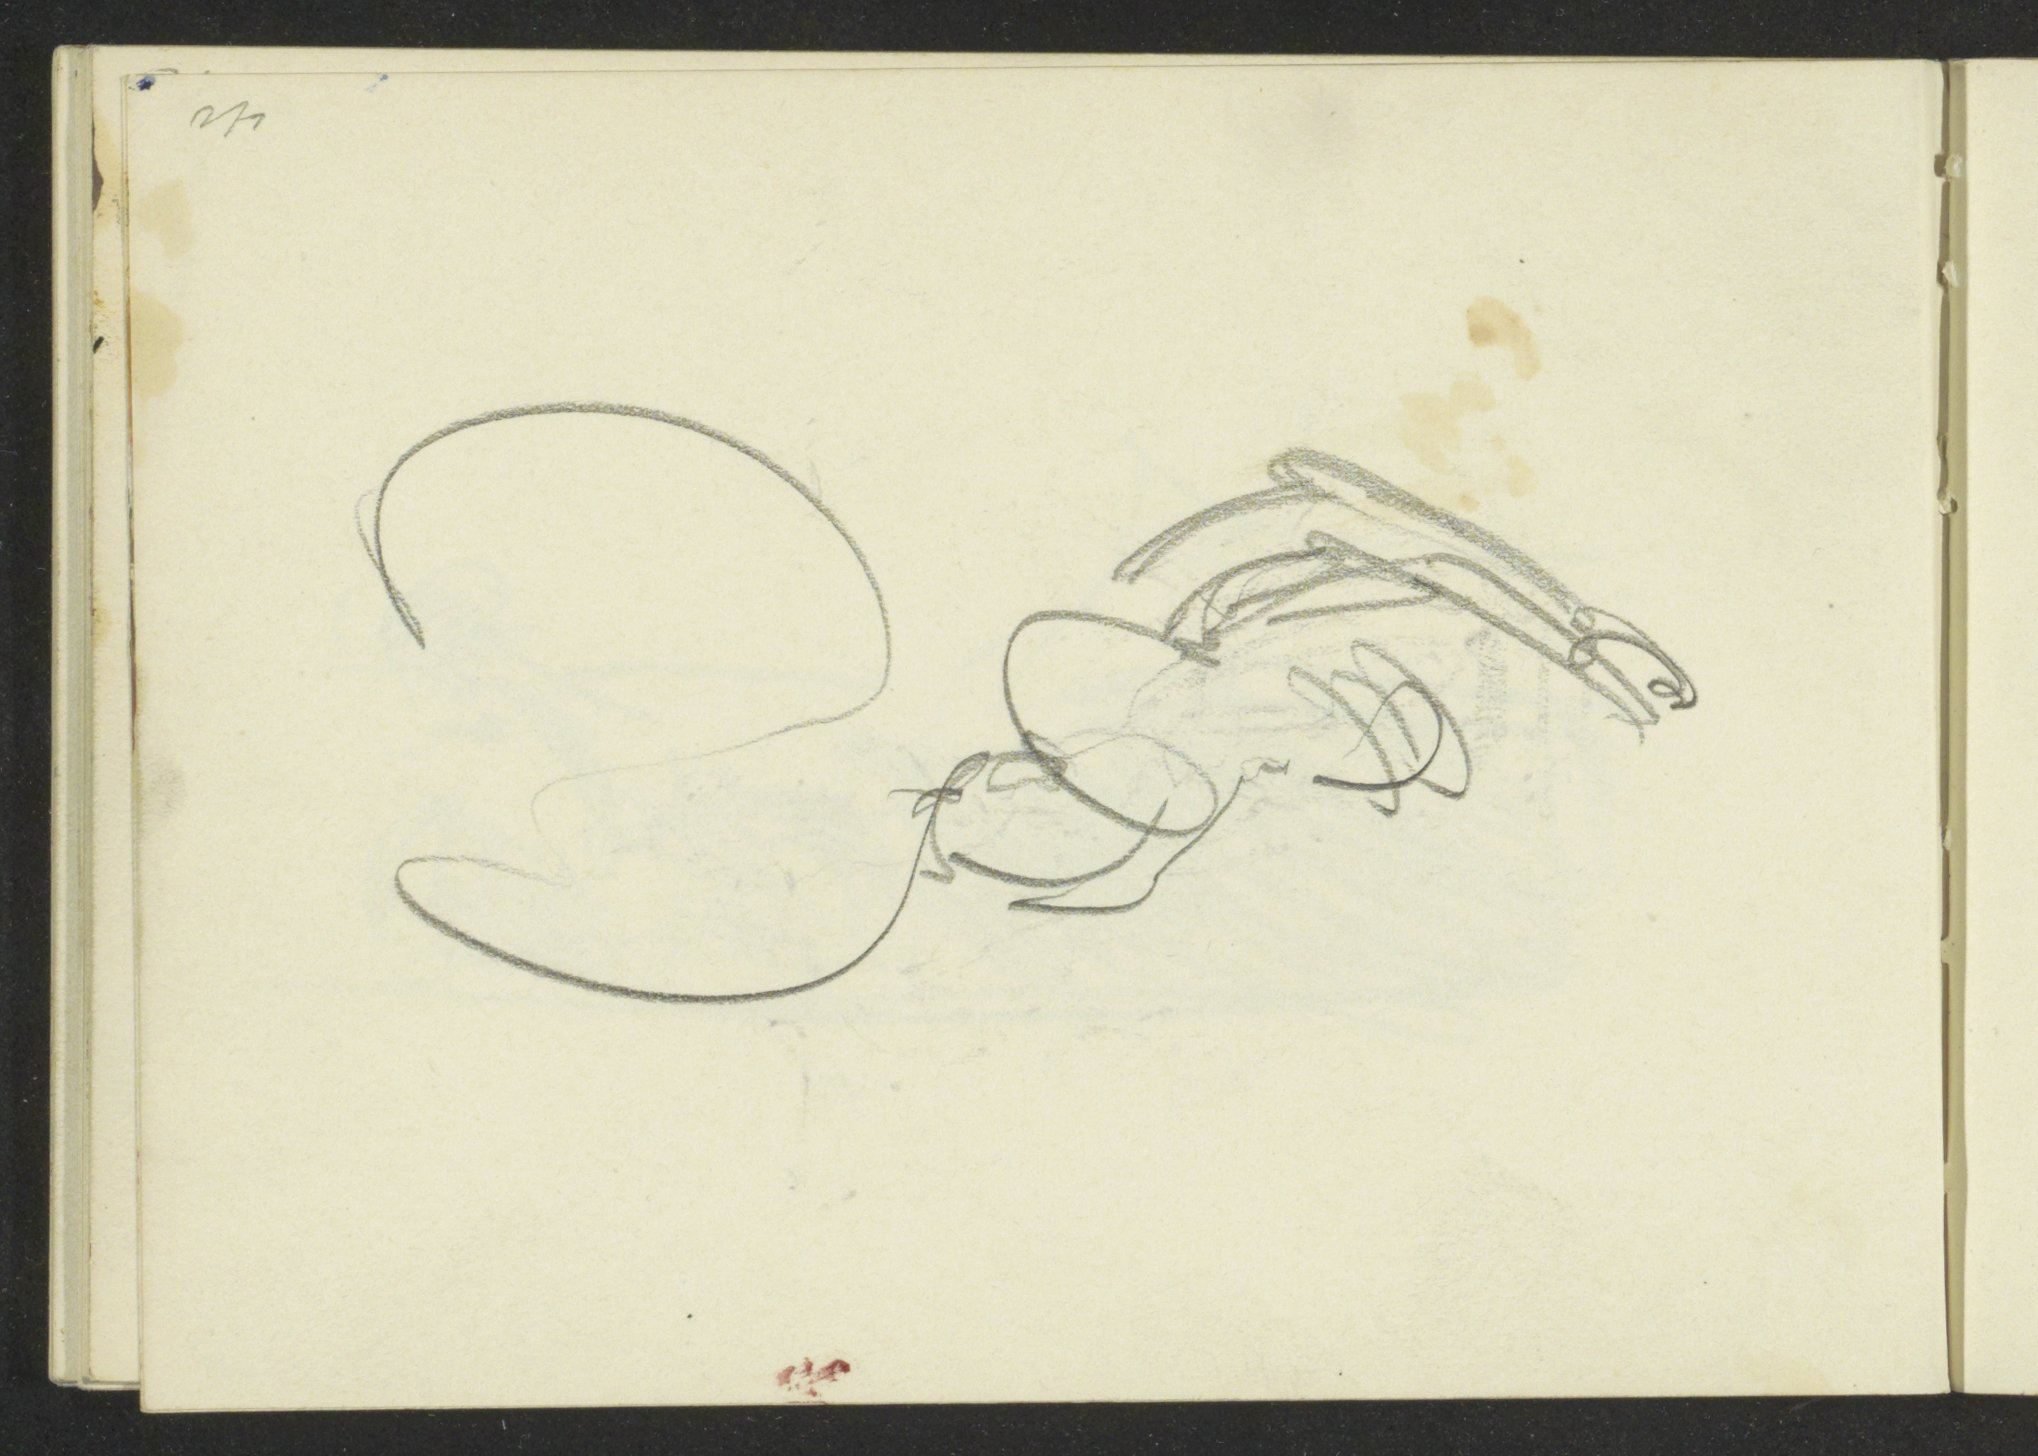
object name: sketchbook leaf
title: Dansende vrouw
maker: isaac israels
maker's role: draughtsman, painter, print maker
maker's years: 1865-1934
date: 1875-1934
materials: paper, pencil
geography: the hague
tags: female dancer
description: Blad 19 verso uit schetsboek LVII met 29 bladen.